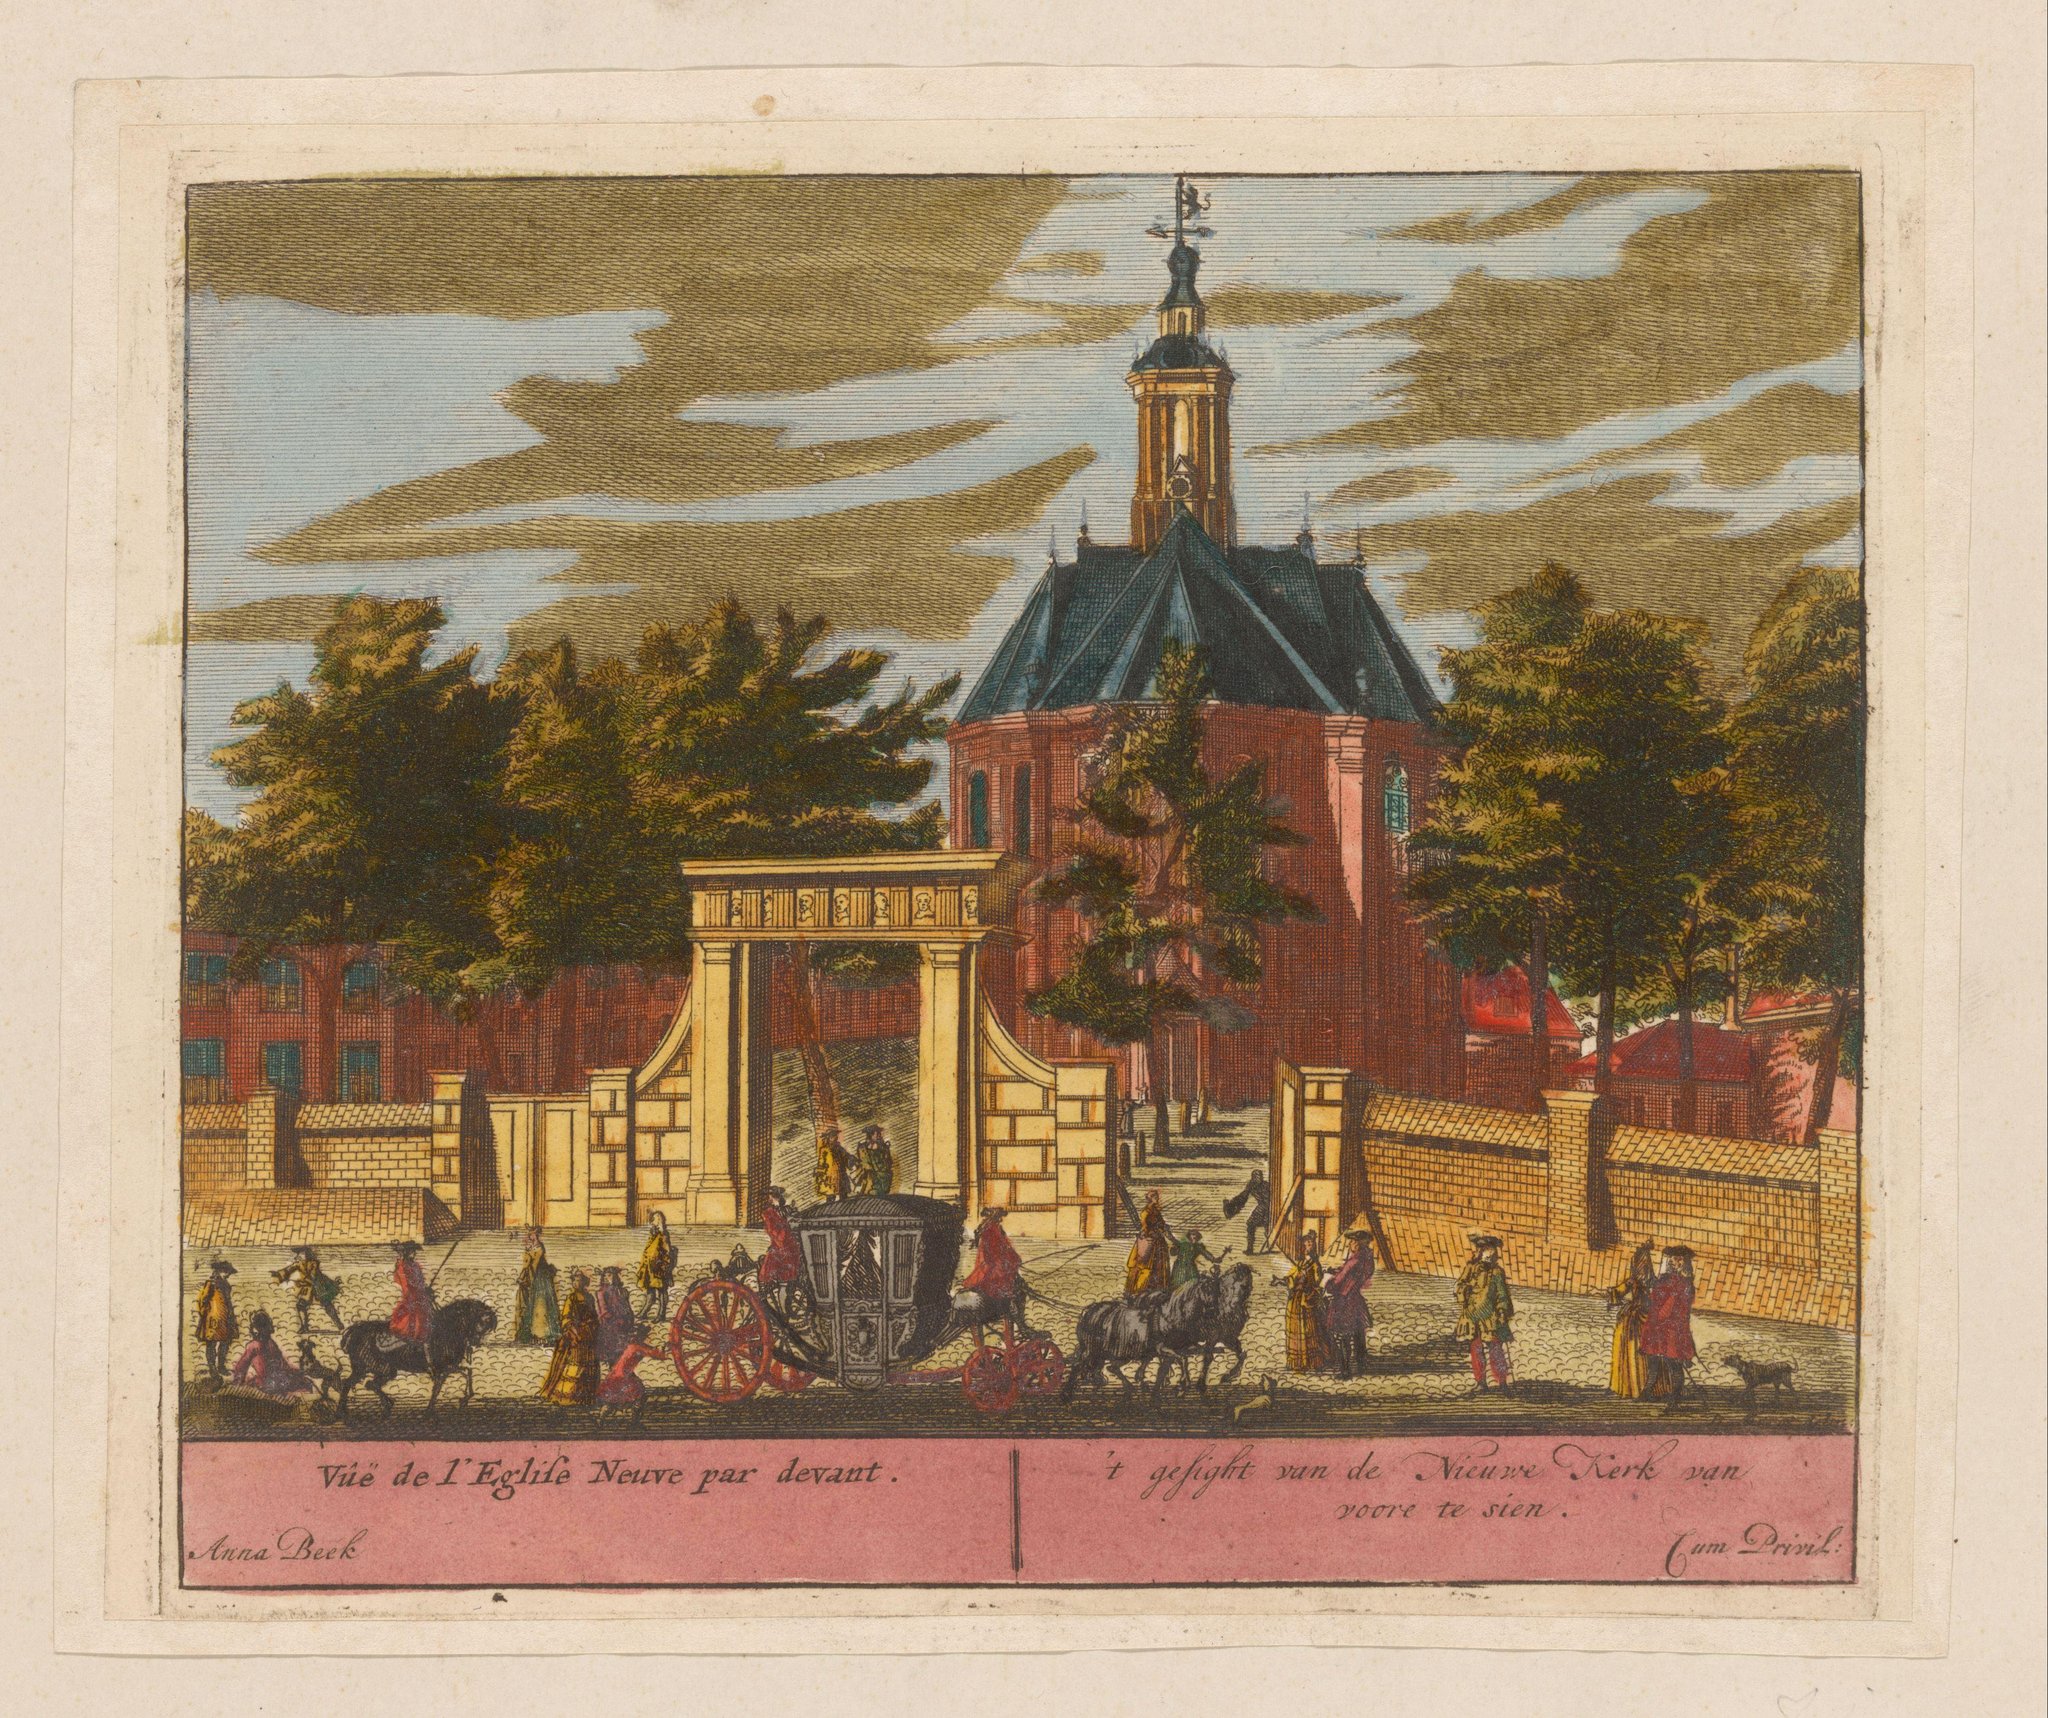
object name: print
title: Gezicht op de Nieuwe Kerk te Den Haag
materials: paper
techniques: etching, hand coloring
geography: the hague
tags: city-view, and landscape with man-made constructions, the place of worship and its equipment ~ christian churches, four-wheeled, animal-drawn vehicle, e.g.: cab, carriage, coach, the hague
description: Mogelijk uitgegeven als onderdeel van een serie van veertien gezichten in Den Haag. Zie ook RP-P-AO-12-34A, RP-P-AO-12-118-1, RP-P-AO-12-118-2, RP-P-AO-12-118-3, RP-P-AO-12-118-4, RP-P-AO-12-118-5, RP-P-AO-12-118-6, RP-P-AO-12-118-7, RP-P-AO-12-118-8, RP-P-AO-12-118-9, RP-P-AO-12-118-11, RP-P-AO-12-118-12, RP-P-AO-12-118-13, RP-P-2016-2145, RP-P-2016-2146, RP-P-2016-2147, RP-P-2016-2148, RP-P-2016-2149, RP-P-2016-2150 en RP-P-2016-2151.